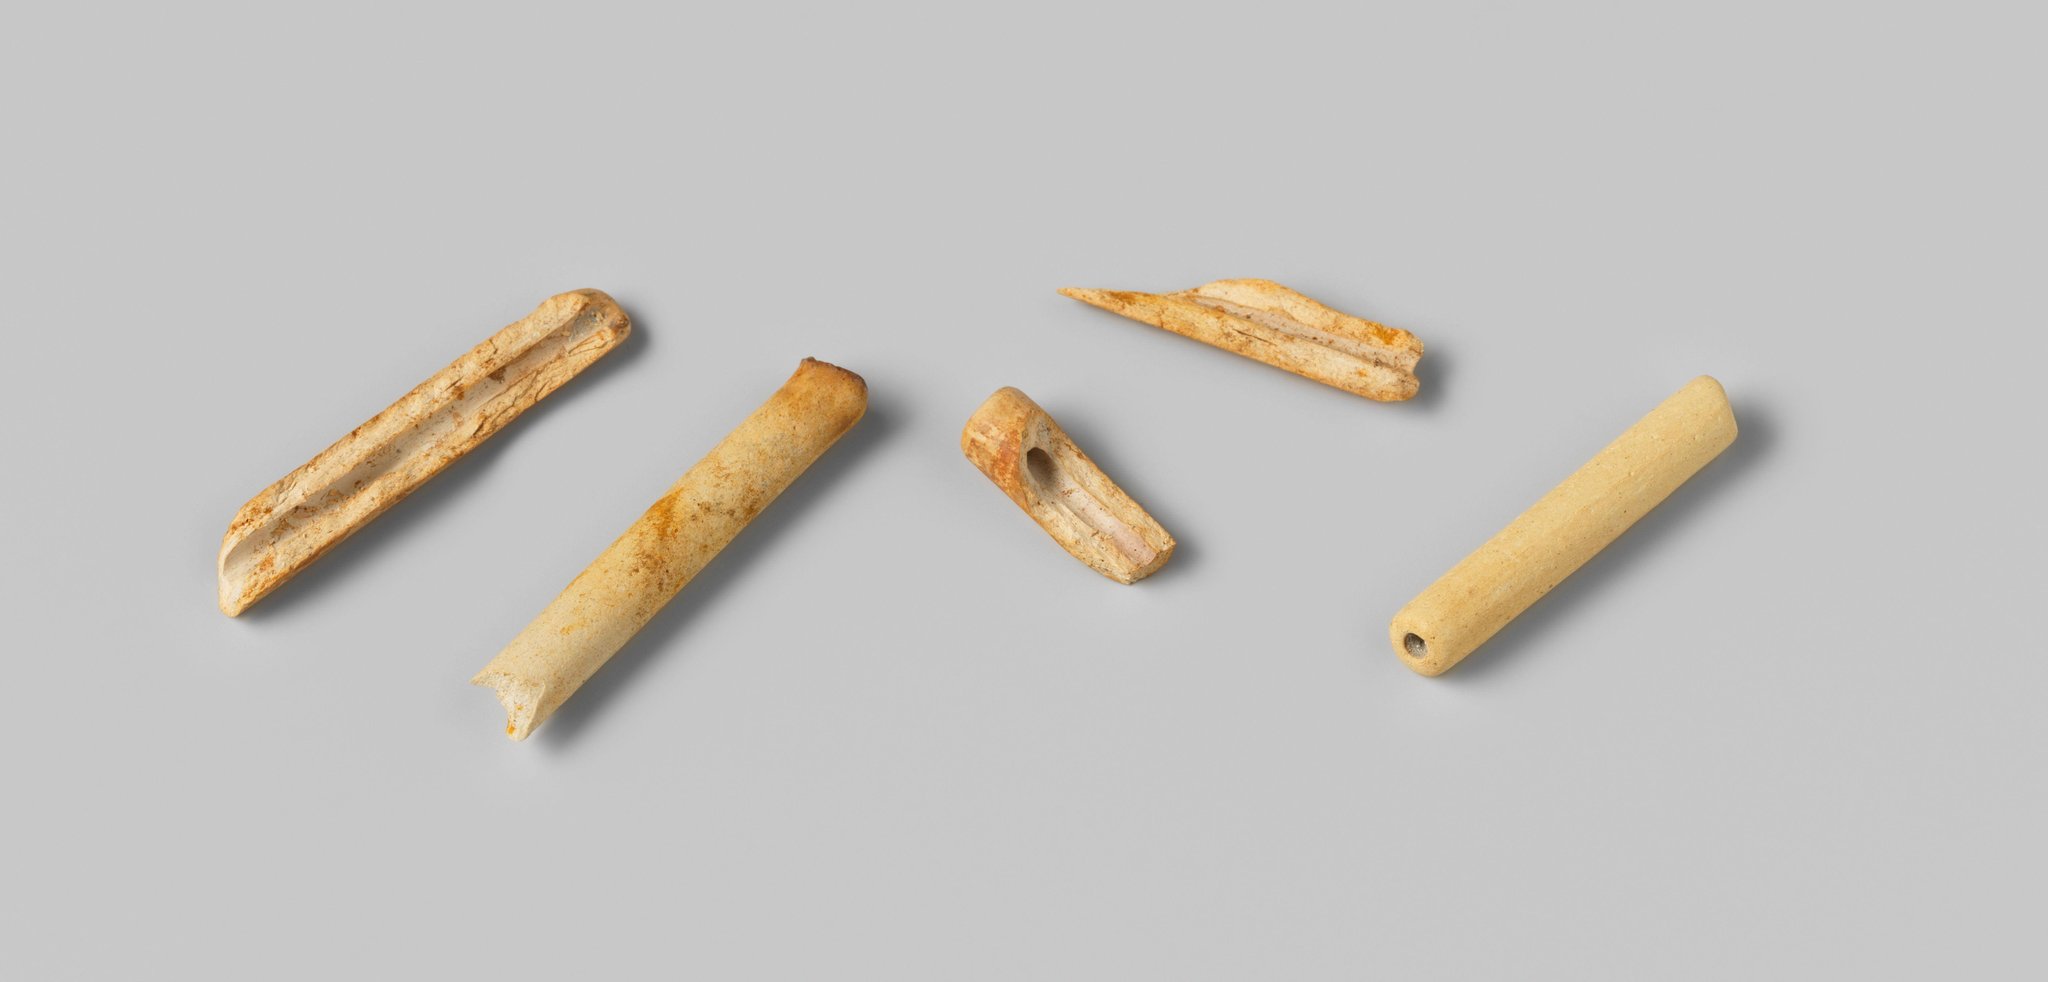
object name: pipe stem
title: Fragmenten pijpenstelen uit het wrak van de Oostindiëvaarder Hollandia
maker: Anonymous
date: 1700-1743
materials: clay